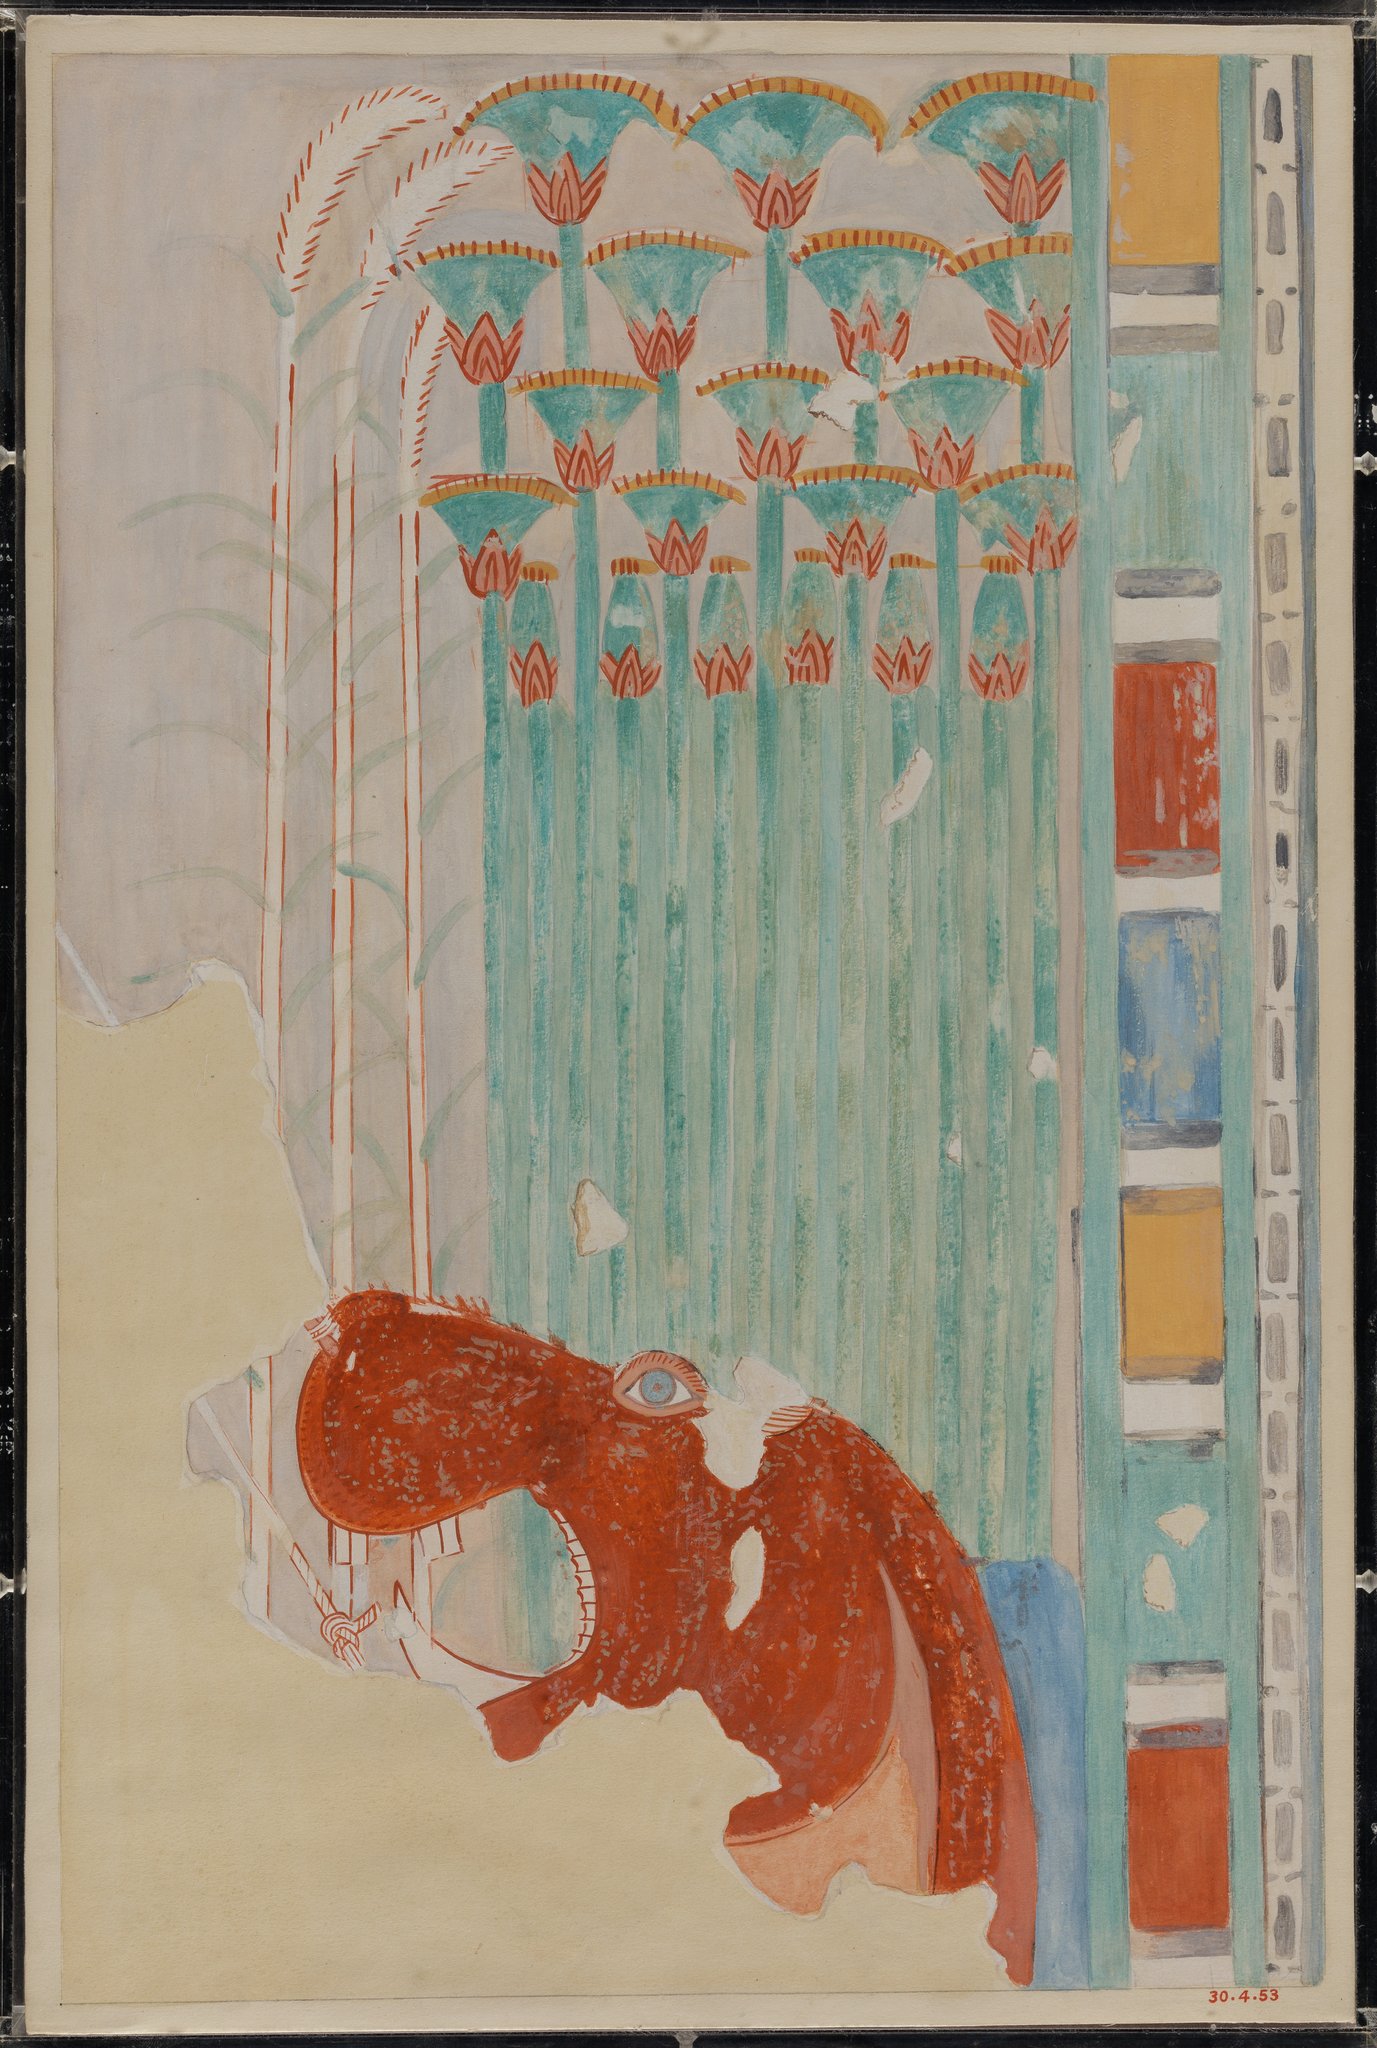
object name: facsimile, amenemhat tt 82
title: Hippopotamus in a Marsh Scene, Tomb of Amenehhat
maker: charles k. wilkinson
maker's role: artist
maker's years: 1897-1986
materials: paper, paint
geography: egypt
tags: animals,hippos